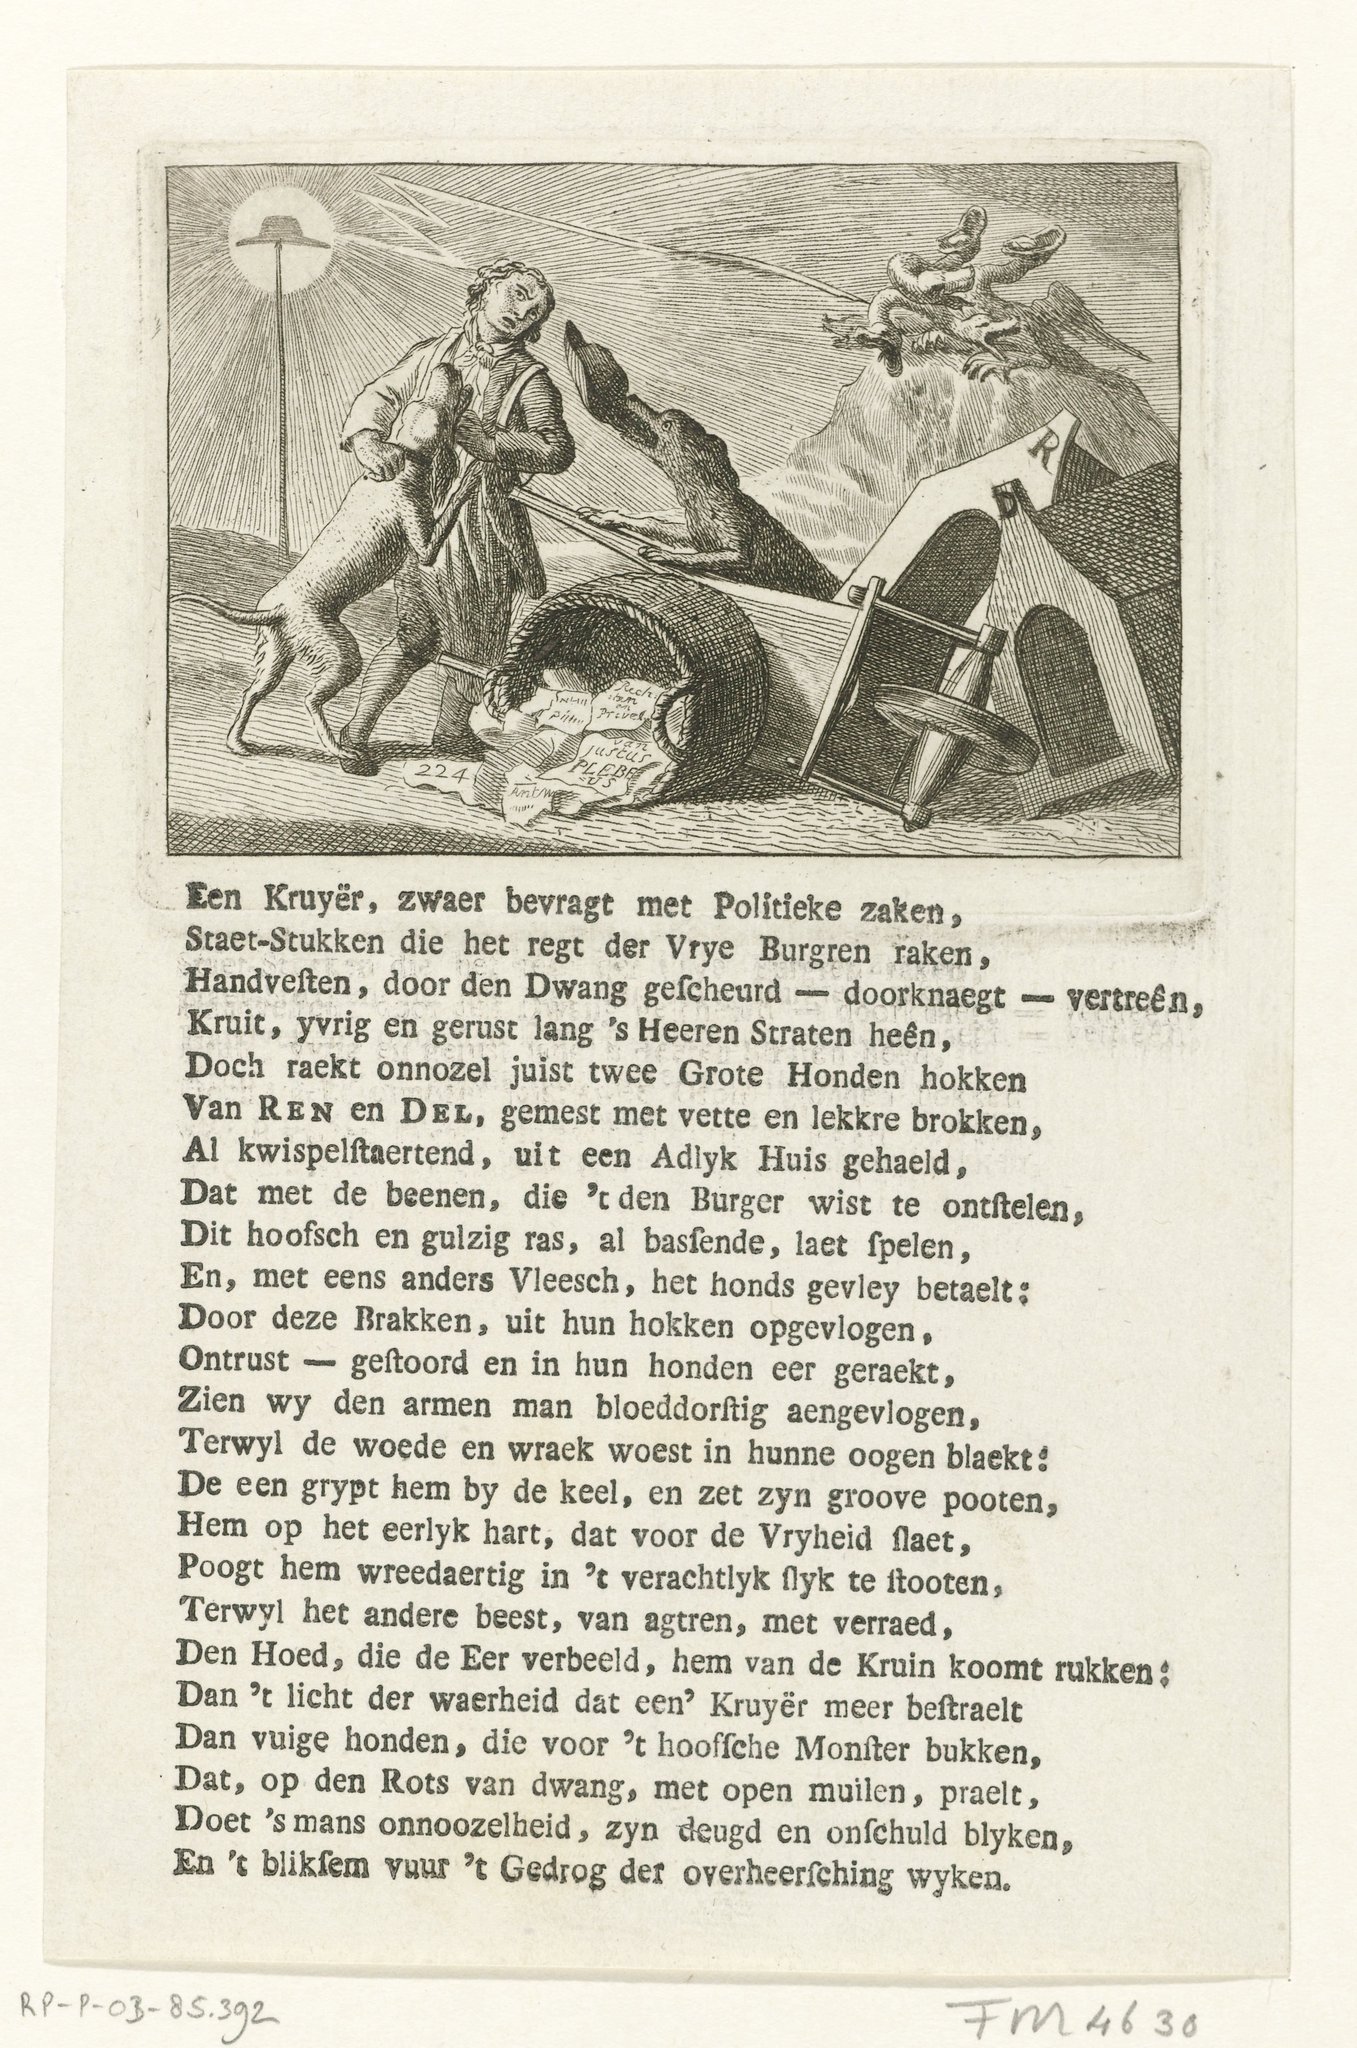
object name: print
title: Spotprent op de rechtszaak aangespannen tegen het patriottisch weekblad De Politieke Kruier, 1785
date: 1785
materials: paper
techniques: engraving, etching, letterpress printing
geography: northern netherlands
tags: dog (+ animal(s) attacking), wheelbarrow (+ wreck ~ traffic accident), patriots (1780-1795)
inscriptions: collector's mark: Lugt 2228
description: Spotprent op de rechtszaak aangespannen op 16 april 1785 door de twee Amsterdamse burgemeesters J. Rendorp en W.G. Dedel tegen J.C. Hespe en J. Verlem, schrijver en uitgever het patriottisch weekblad De Politieke Kruier. Een kruier wordt aangevallen door twee honden. Op de achtergrond wordt een zevenkoppig monster getroffen door de bliksem van de stralende vrijheidshoed. Op het blad onder de plaat een vers van 24 regels.